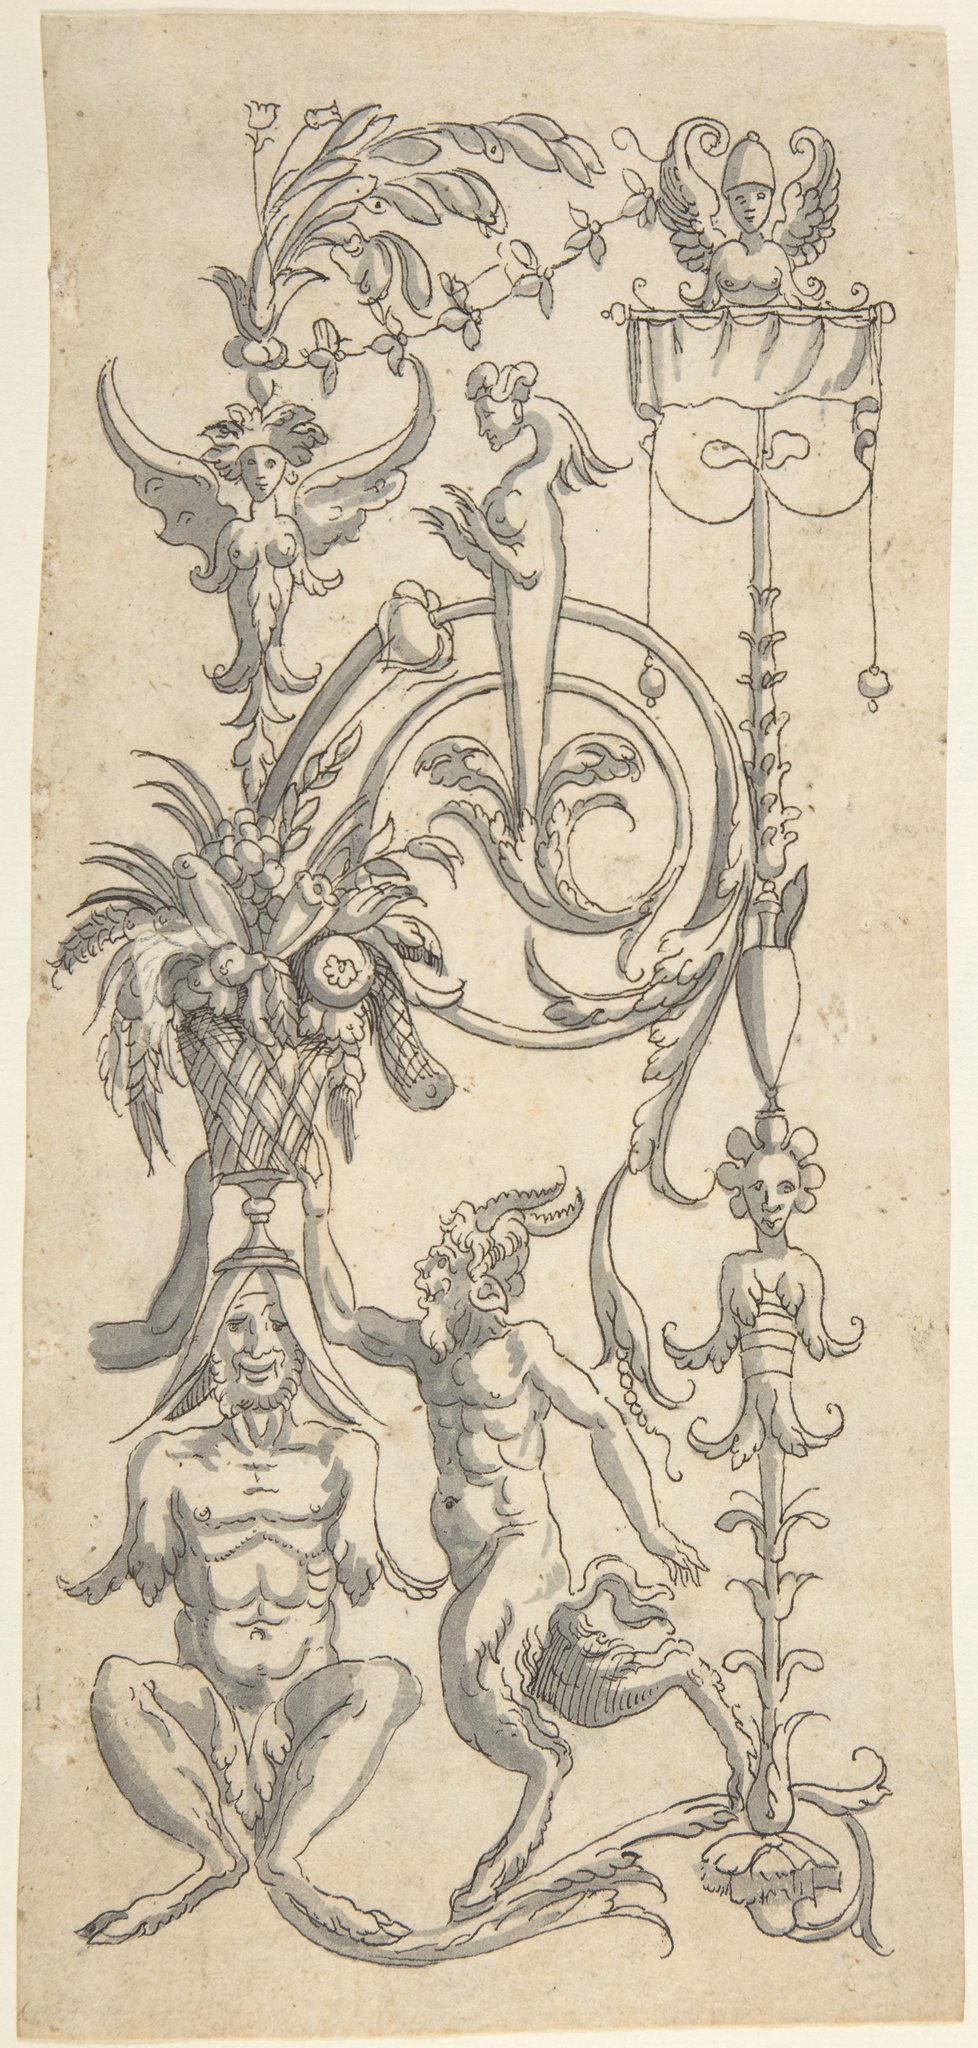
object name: ornament architecture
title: Candelabra Grotesque with a Crouched Satyr Carrying a Fruit Basket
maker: anonymous, italian, 16th century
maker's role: artist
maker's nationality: italian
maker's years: 1500-1600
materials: ink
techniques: brush, pen, wash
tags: ornament,satyrs